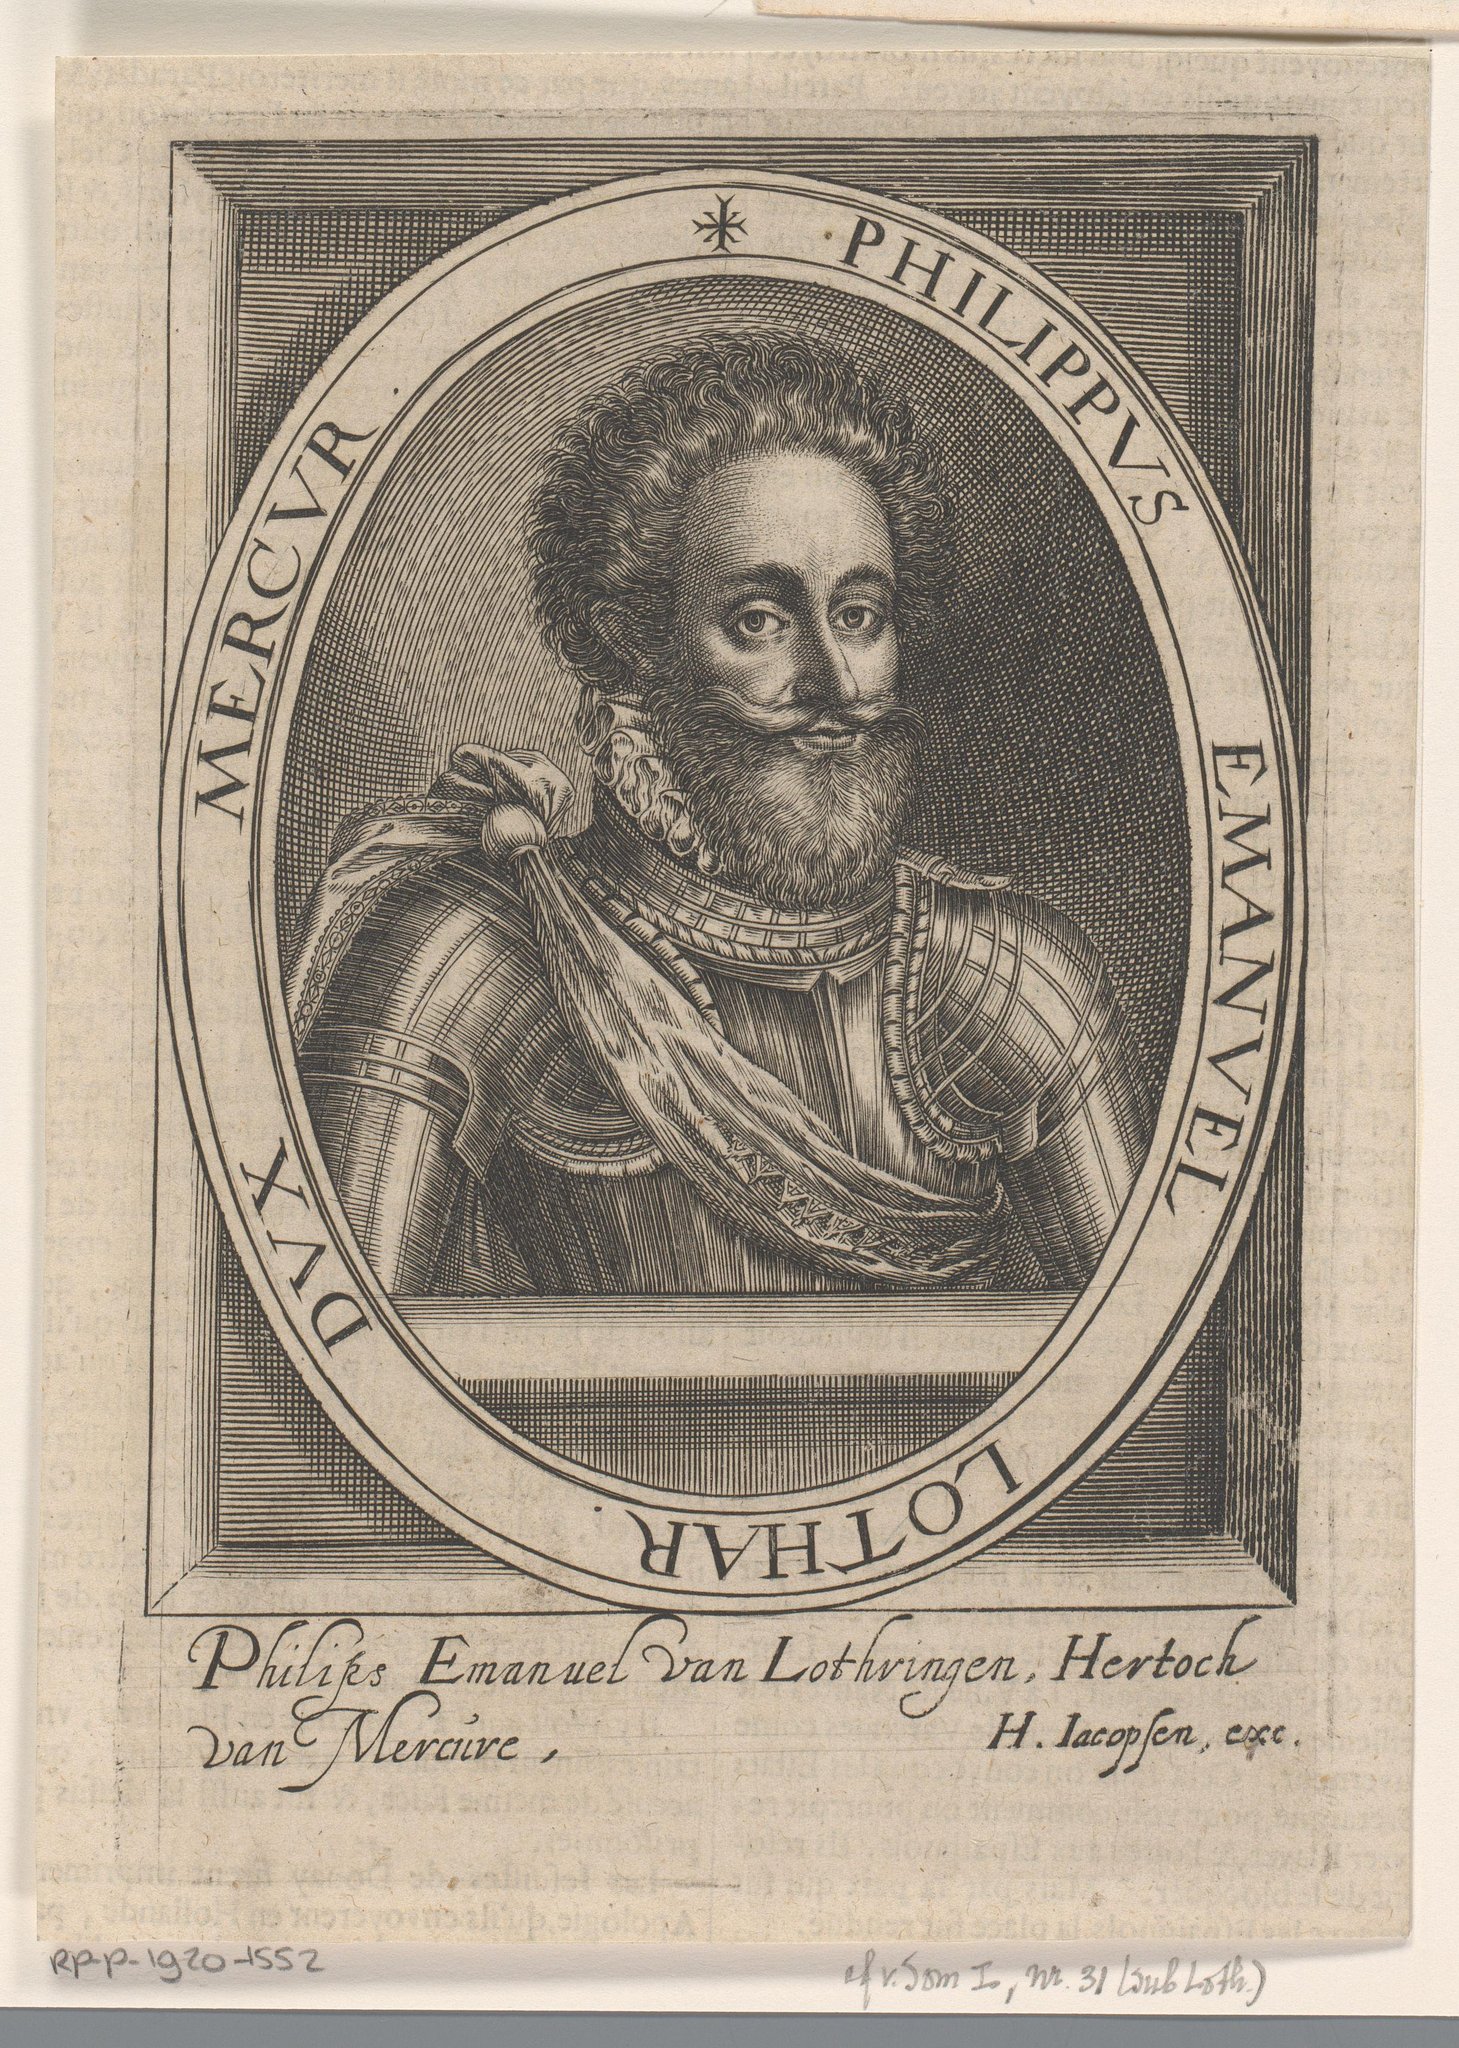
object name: book illustration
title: Philippus Emanuel Lothar Dux Mercur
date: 1618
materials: paper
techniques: engraving, letterpress printing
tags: historical persons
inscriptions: collector's mark: Lugt 2228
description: Prent waarschijnlijk uit: Meteren, Emanuel van. L'Histoire des Pays-Bas (...). Hillebrant Jacobsz. van der Wouw, 1618, p. 420.